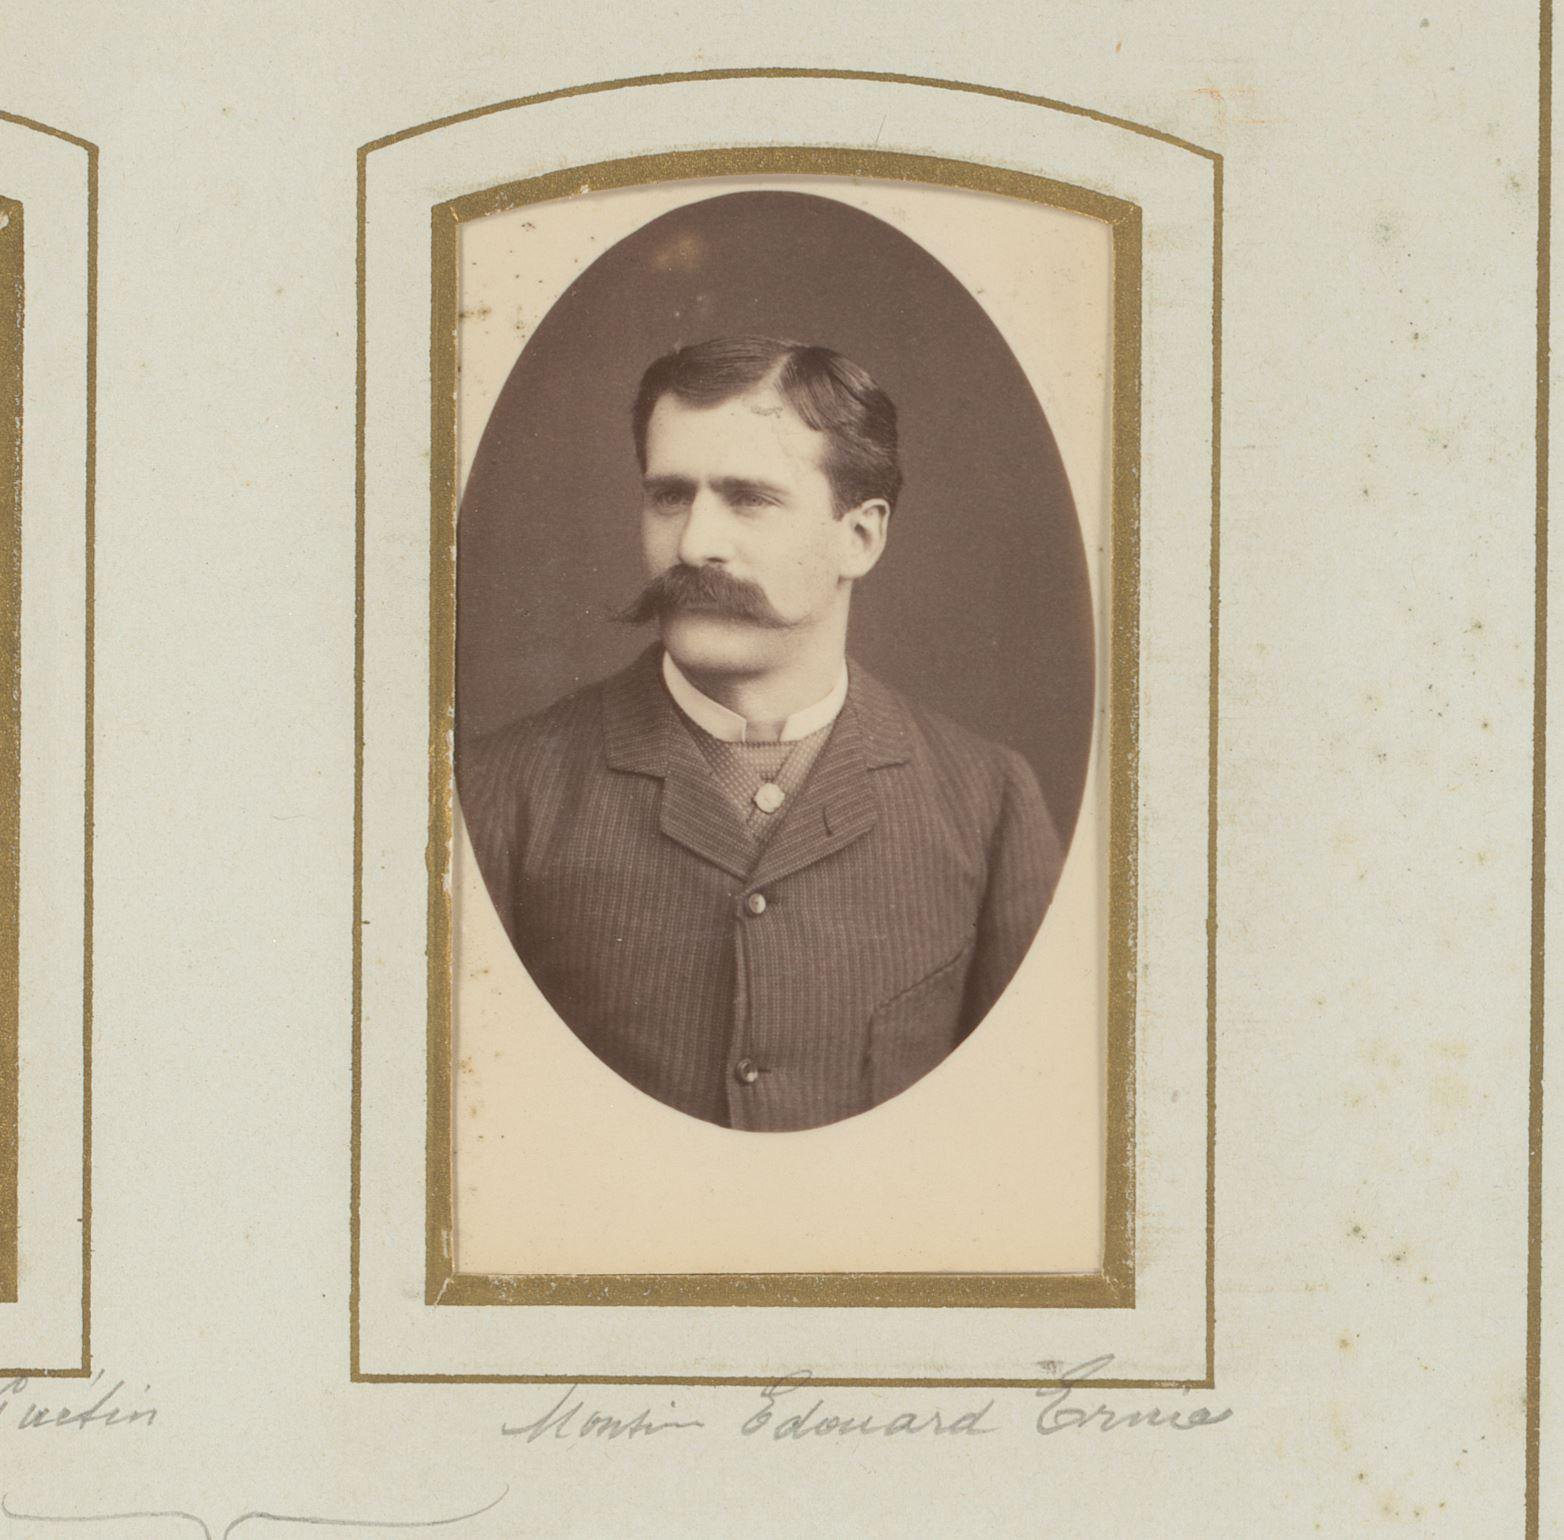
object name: photograph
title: Portret van Henri Edouard Ernie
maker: jean théodore jamin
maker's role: fotograaf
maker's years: -1867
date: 1880-1900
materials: cardboard, celluloid, photographic support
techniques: albumen print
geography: paris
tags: moustache, historical persons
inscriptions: name: ‘Henri Edouard Ernie’, inscription: ‘PHOTOGRAPHIE/ JAMIN/ (Bte S.G.D.G.)/ 13, Rue Chapon 13,/ HÔTEL DE MONTBRISON/ Paris’